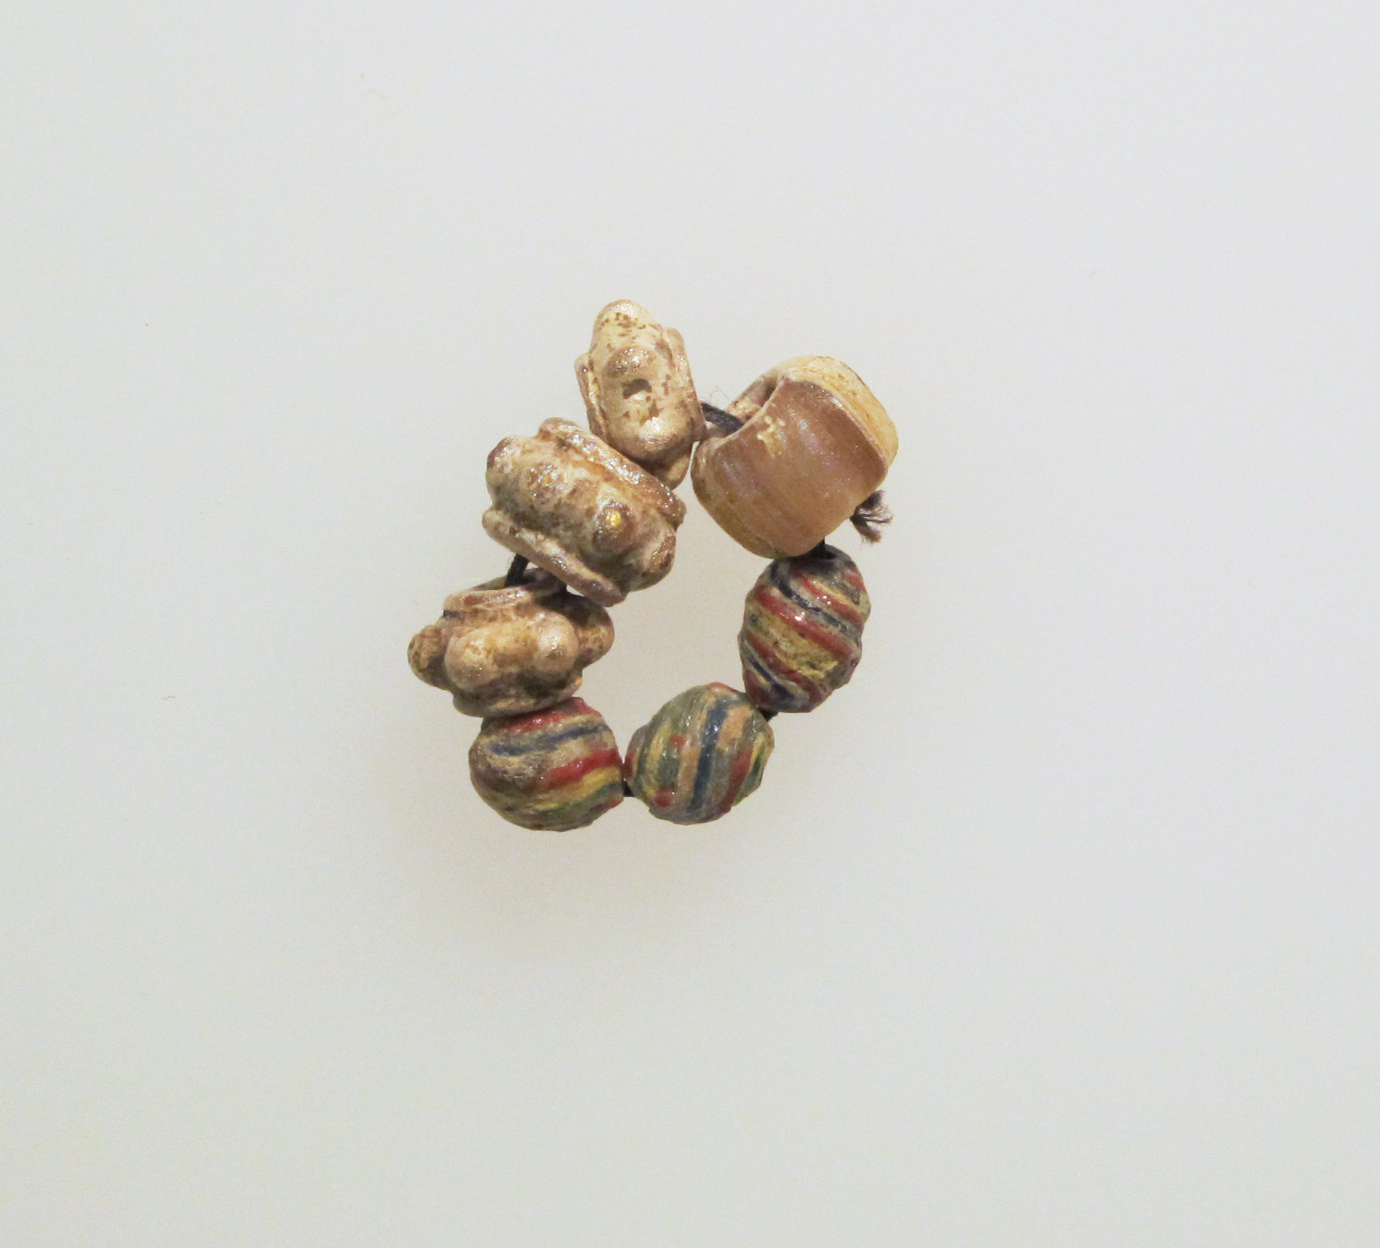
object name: bead, 7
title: Beads, 7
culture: roman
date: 670 BCE-330 CE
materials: glass